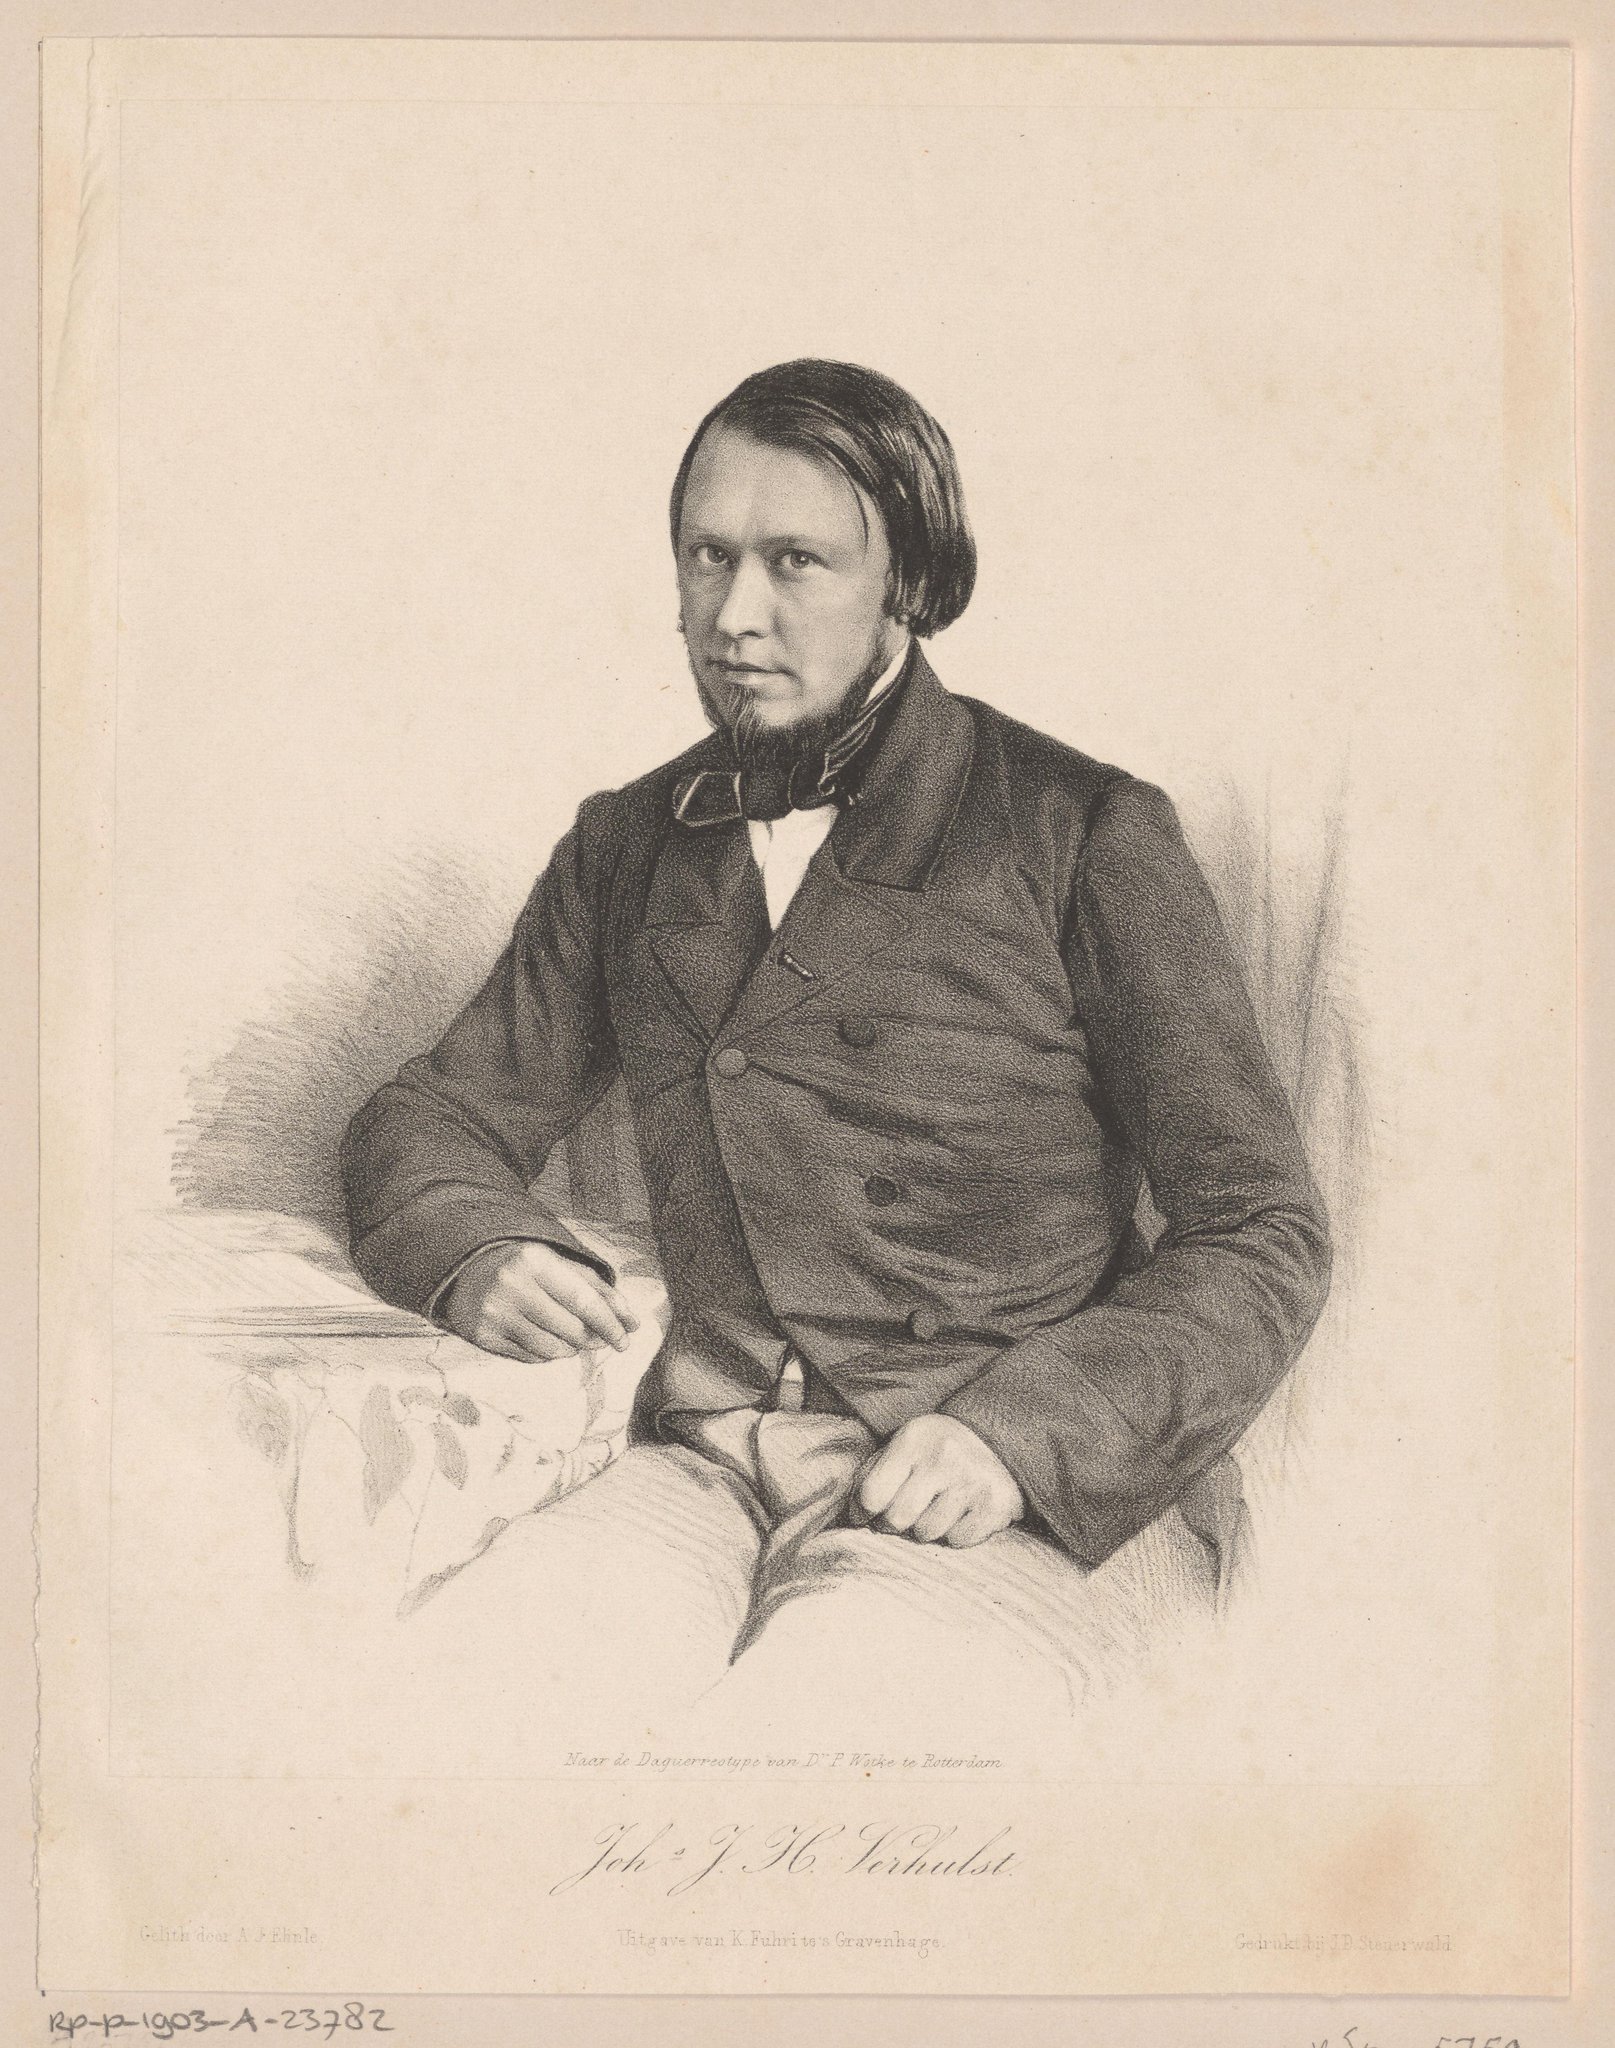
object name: print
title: Portret van Johannes Verhulst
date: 1837-1856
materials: paper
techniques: lithograph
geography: the hague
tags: the hague, johannes verhulst, historical persons, portrait of composer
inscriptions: collector's mark: Lugt 2228